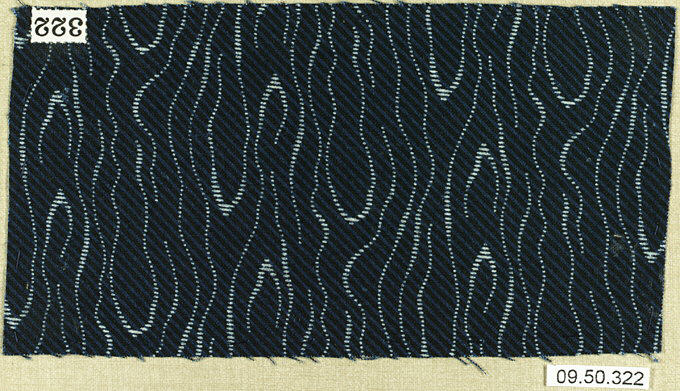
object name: piece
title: Piece (one of 116)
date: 1801-1900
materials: cotton